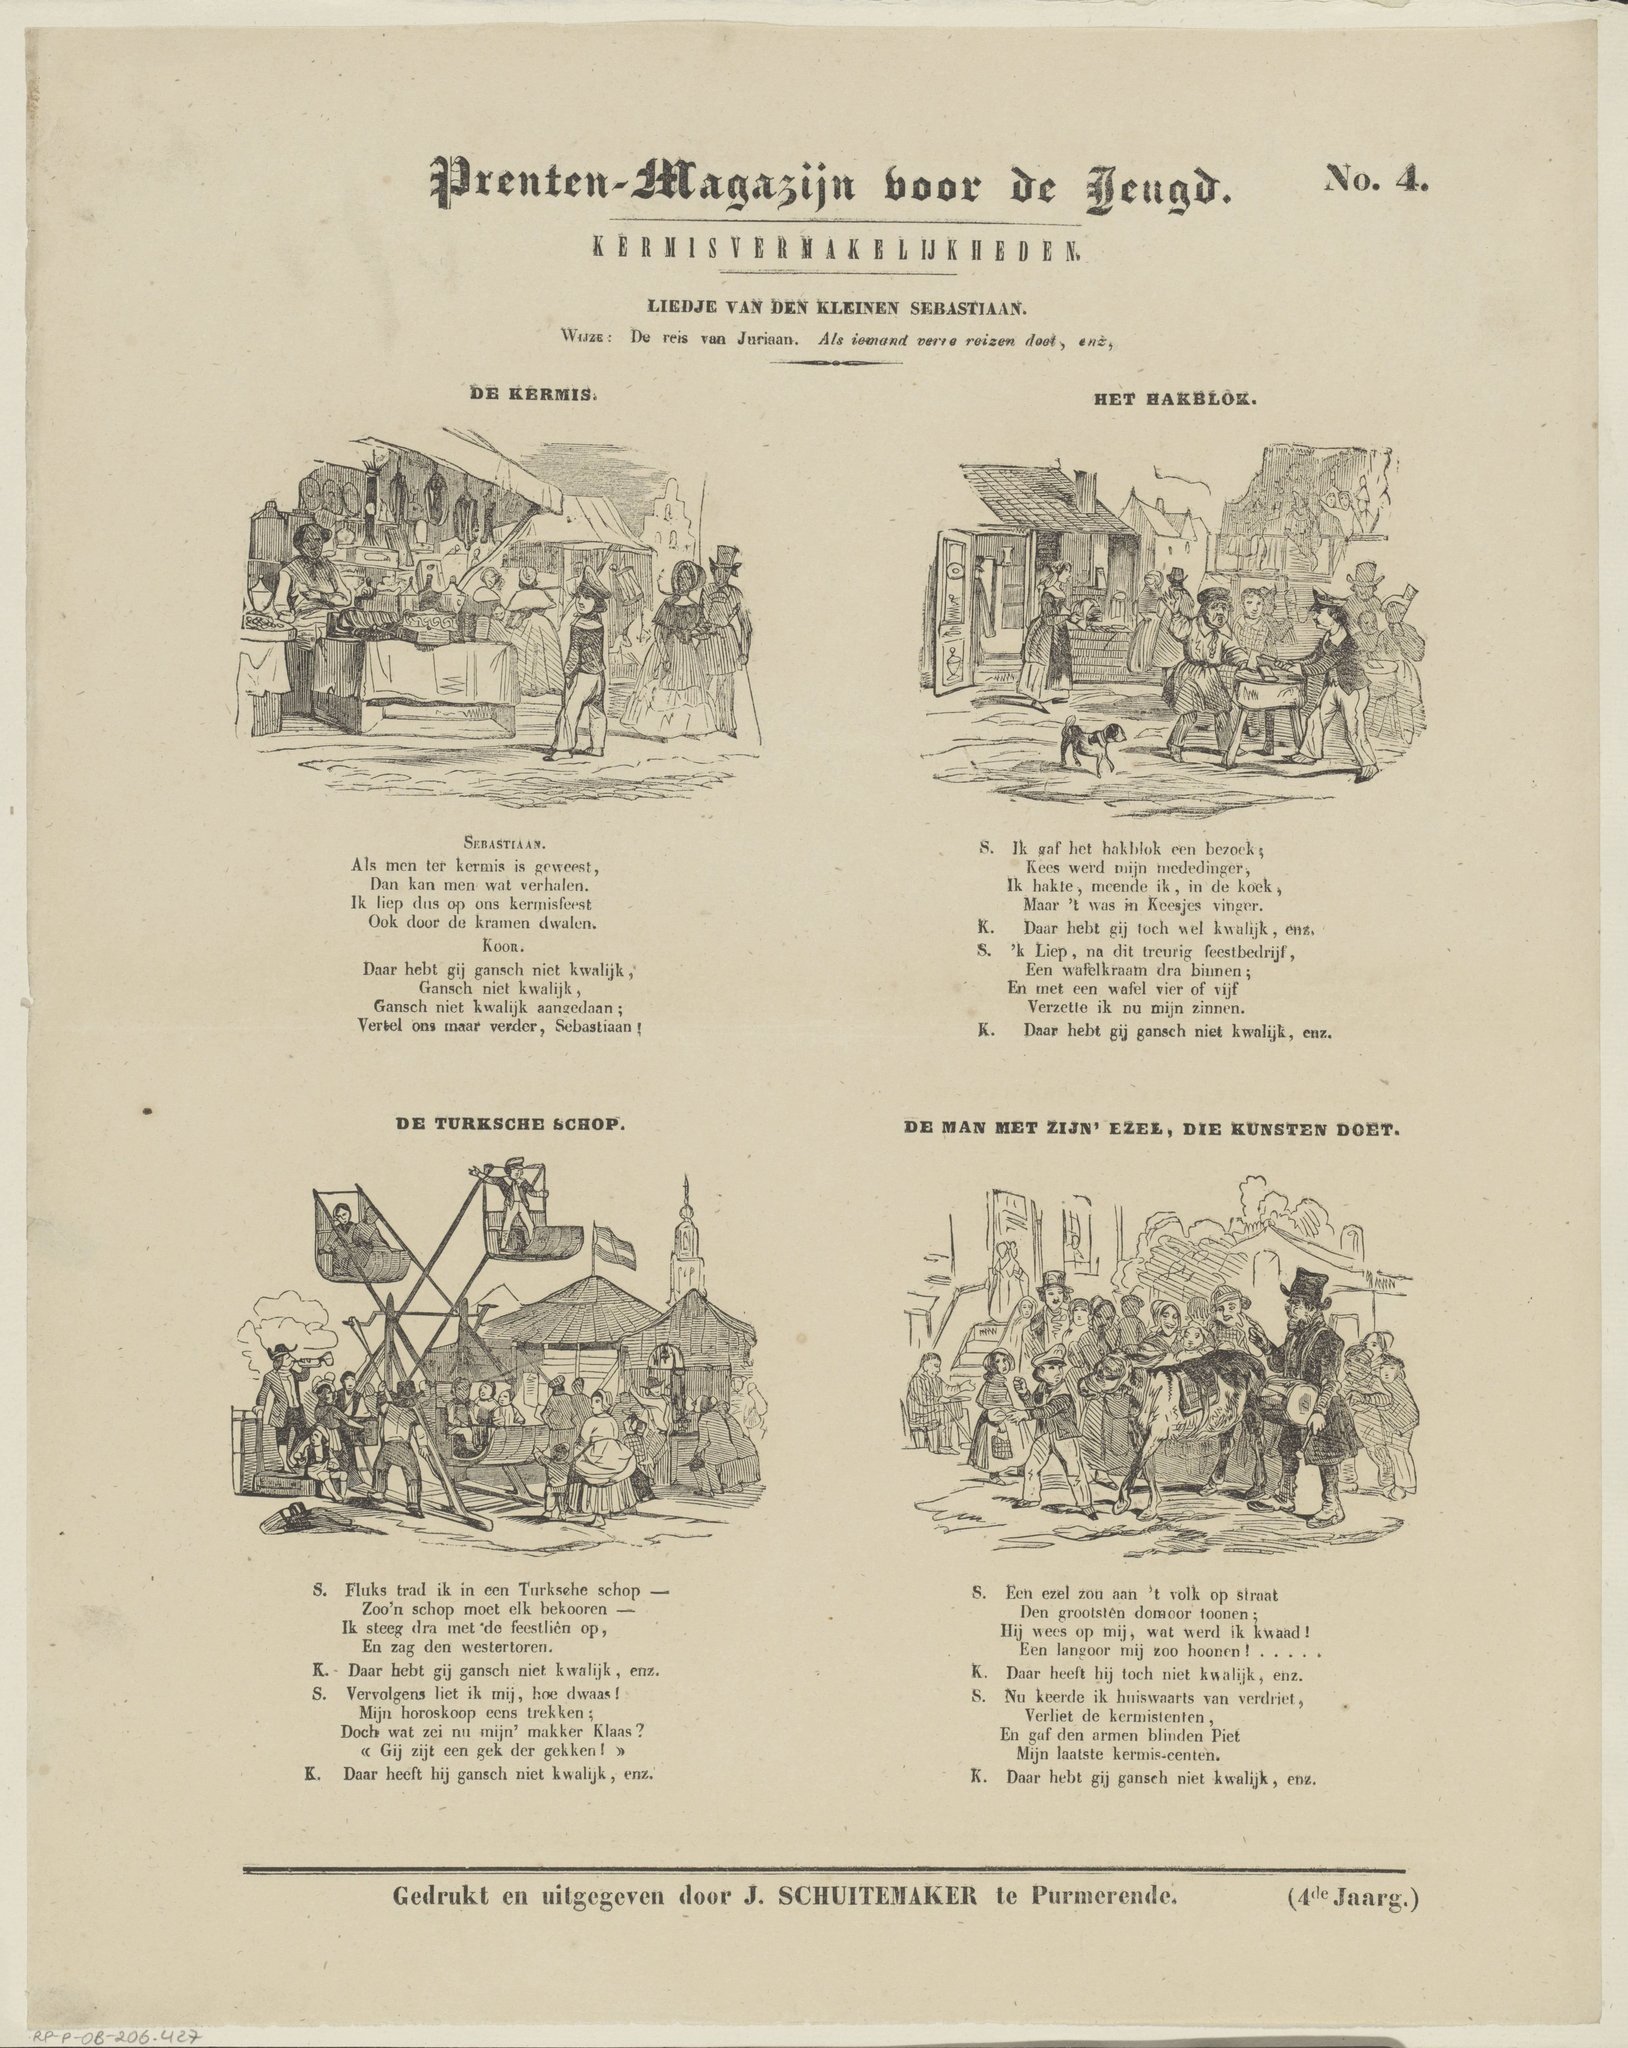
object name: print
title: Kermisvermakelijkheden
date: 1845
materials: paper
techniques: letterpress printing, engraving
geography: purmerend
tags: fancy fair, performance in the open air (pleasure fair), pleasure fair and circus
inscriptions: collector's mark: Lugt 2760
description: Blad met 4 kermistaferelen. Boven elke voorstelling een titel en onder elke voorstelling verzen uit het liedje van de kleine Sebastiaan. Genummerd rechtsboven: No. 4.